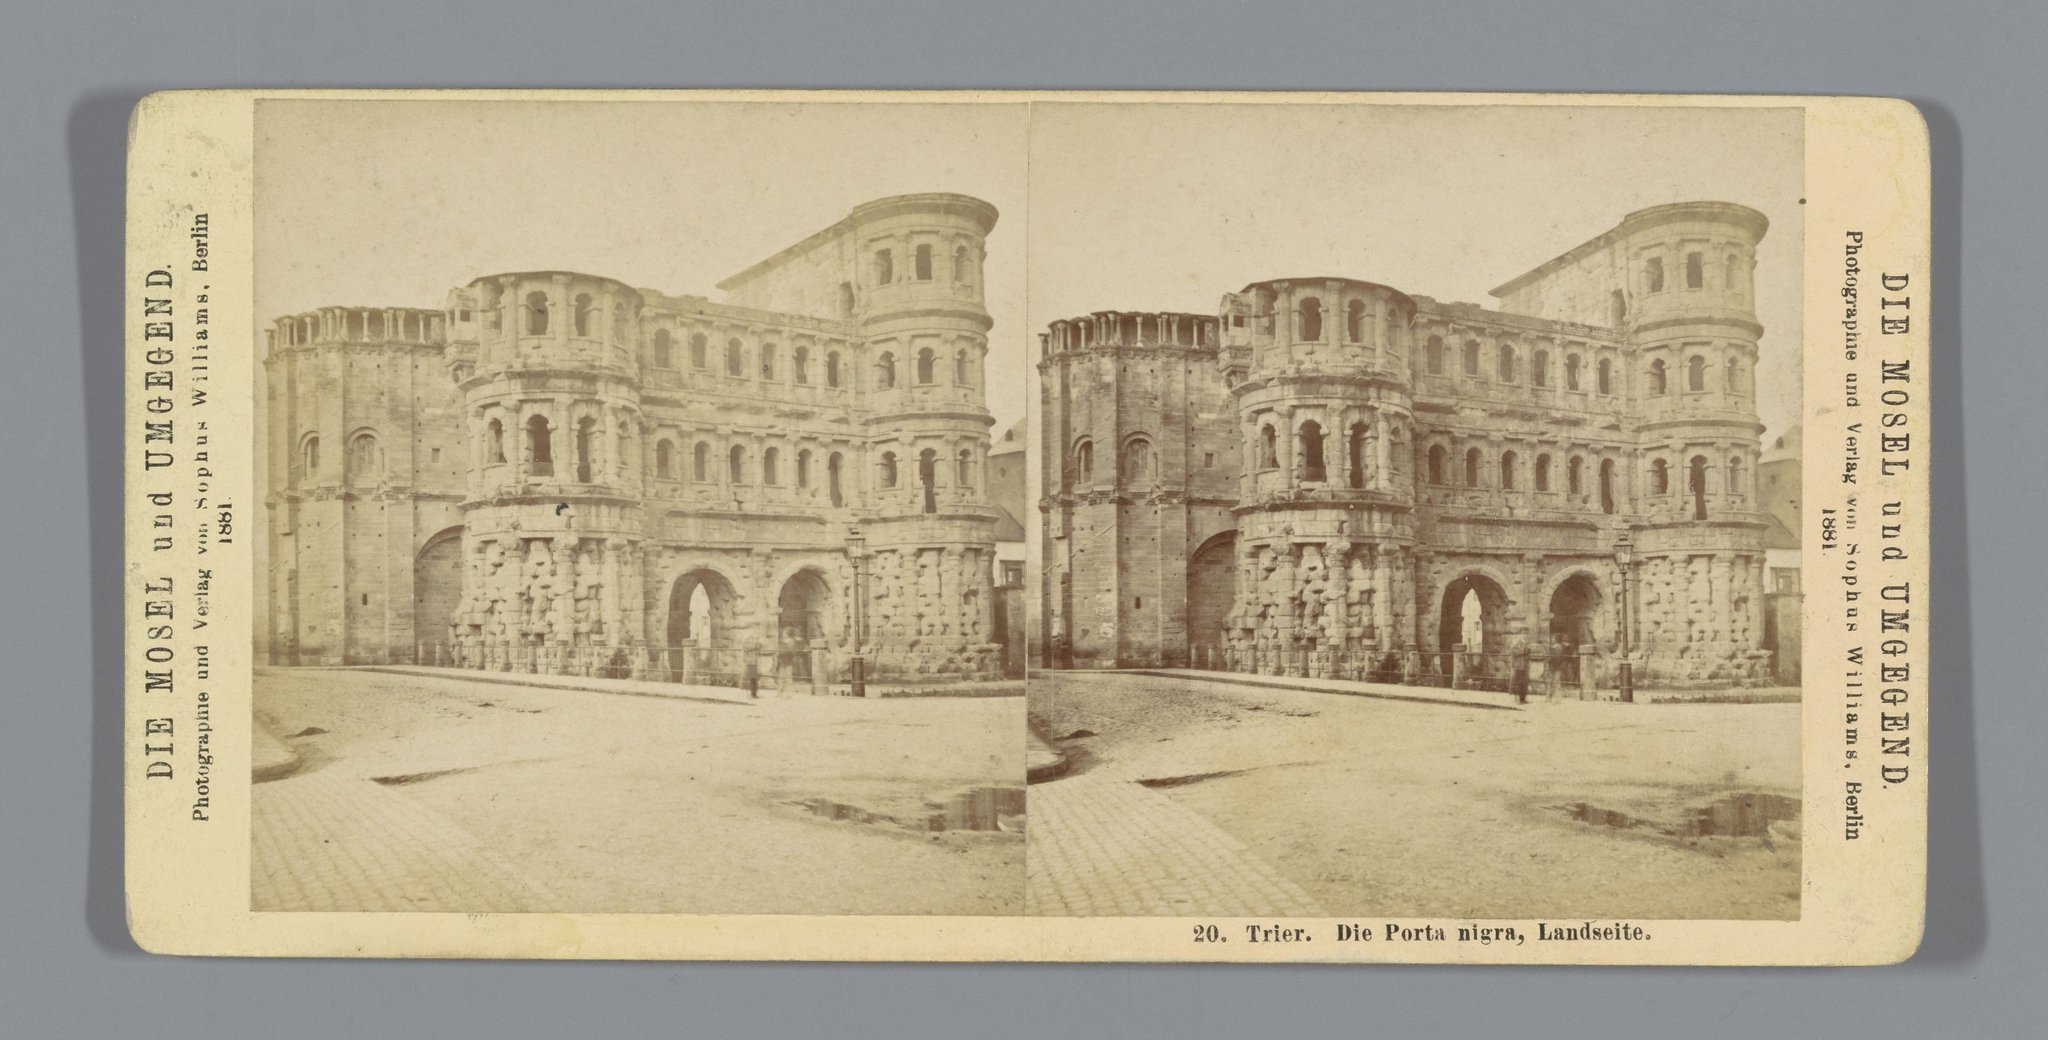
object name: stereograph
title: Porta Nigra te Trier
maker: sophus williams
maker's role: publisher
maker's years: 1835-1900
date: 1881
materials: cardboard, photographic support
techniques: albumen print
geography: trier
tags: city-gate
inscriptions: number: ‘20.’